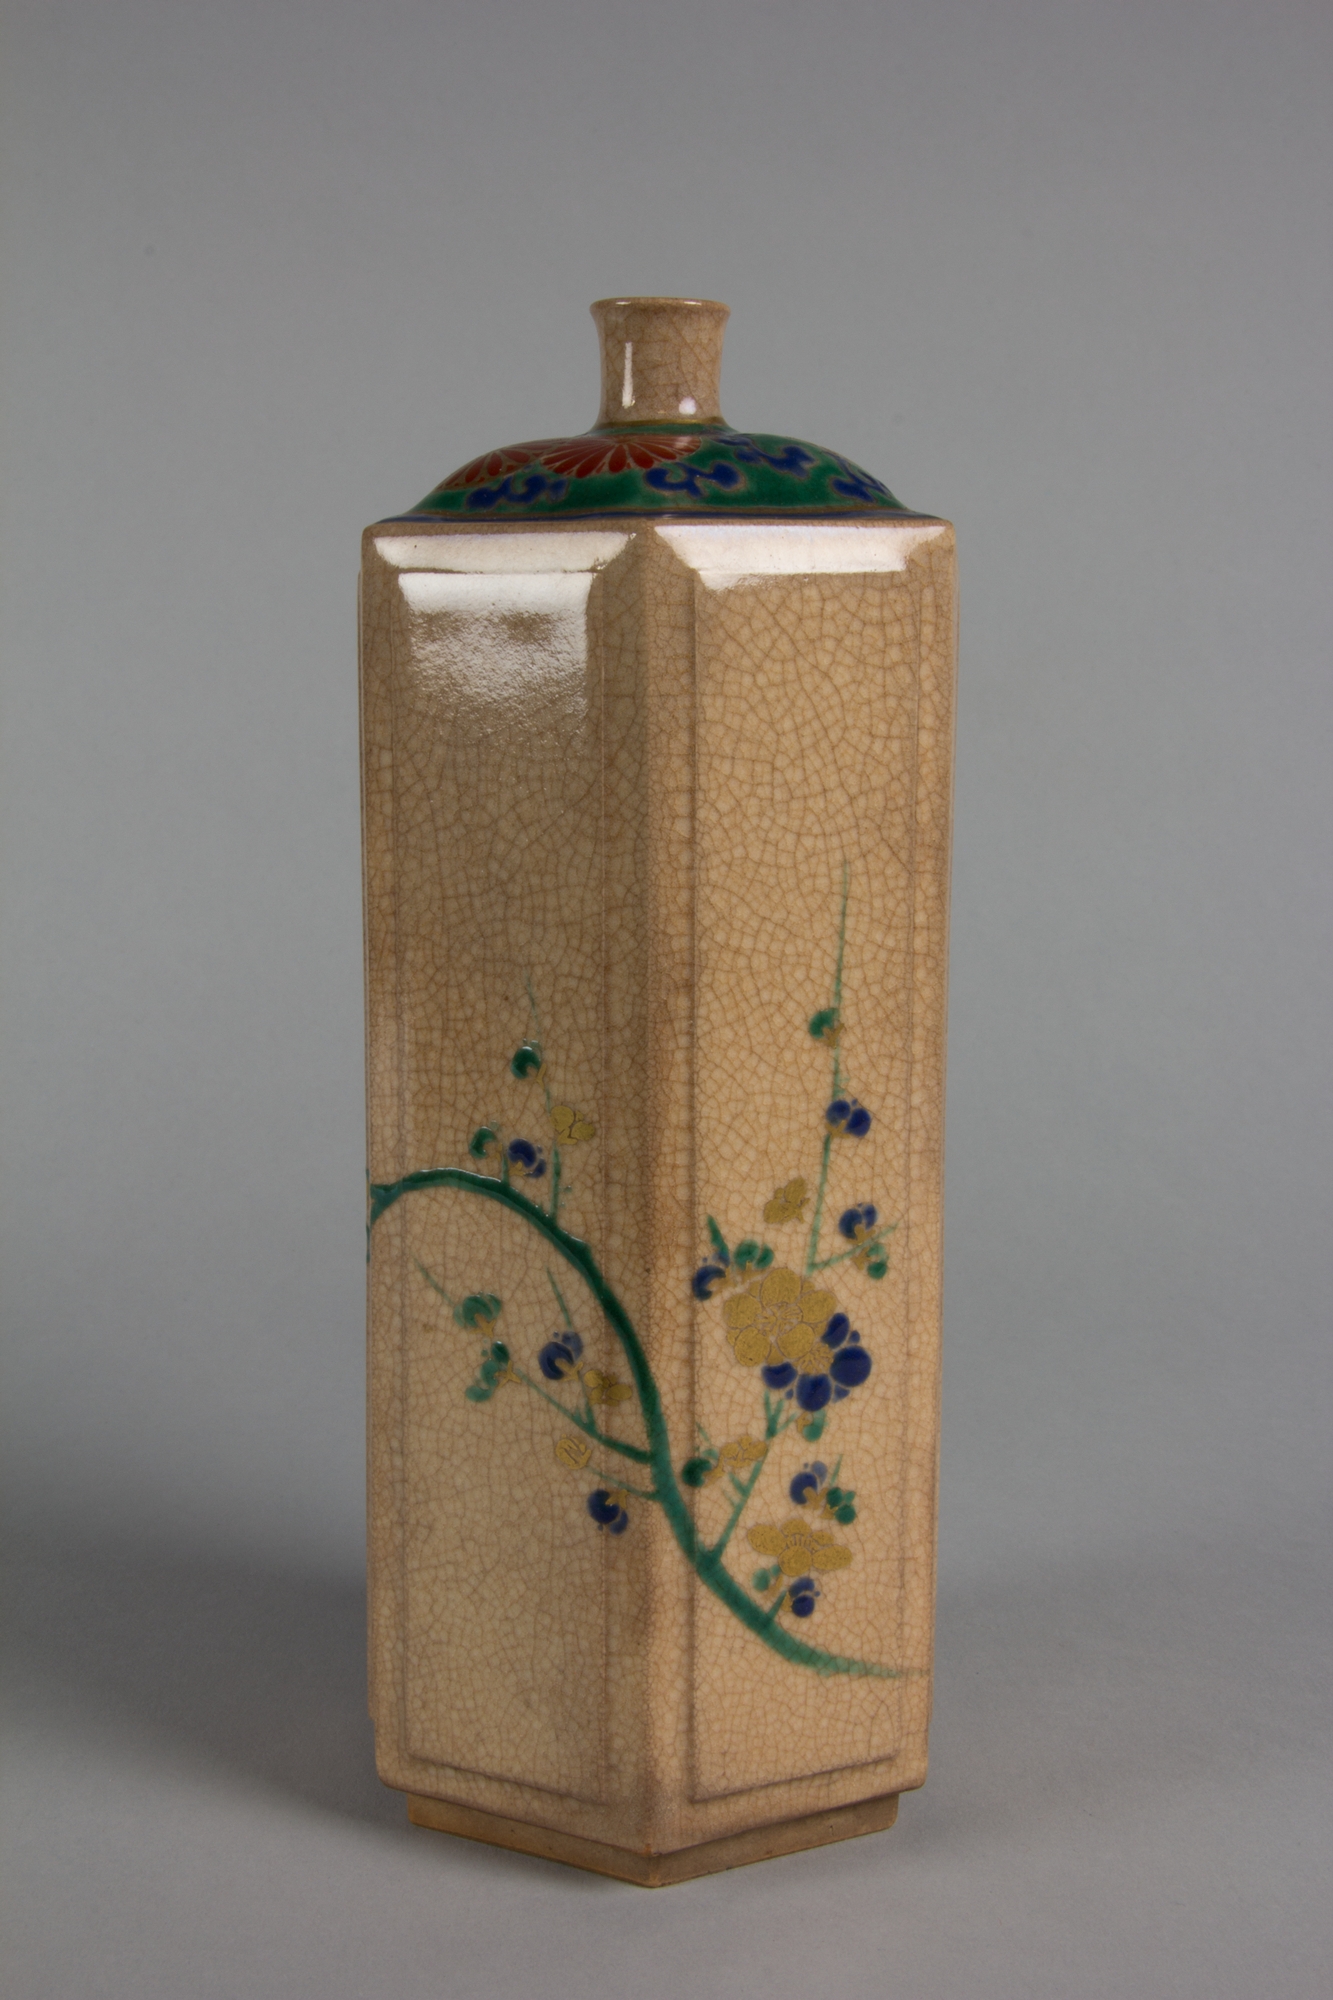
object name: bottle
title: Bottle Decorated with "Three Friends" Pine, Bamboo and Plum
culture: japanese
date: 1734-1766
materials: enamel, glaze, gold, stoneware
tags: flowers